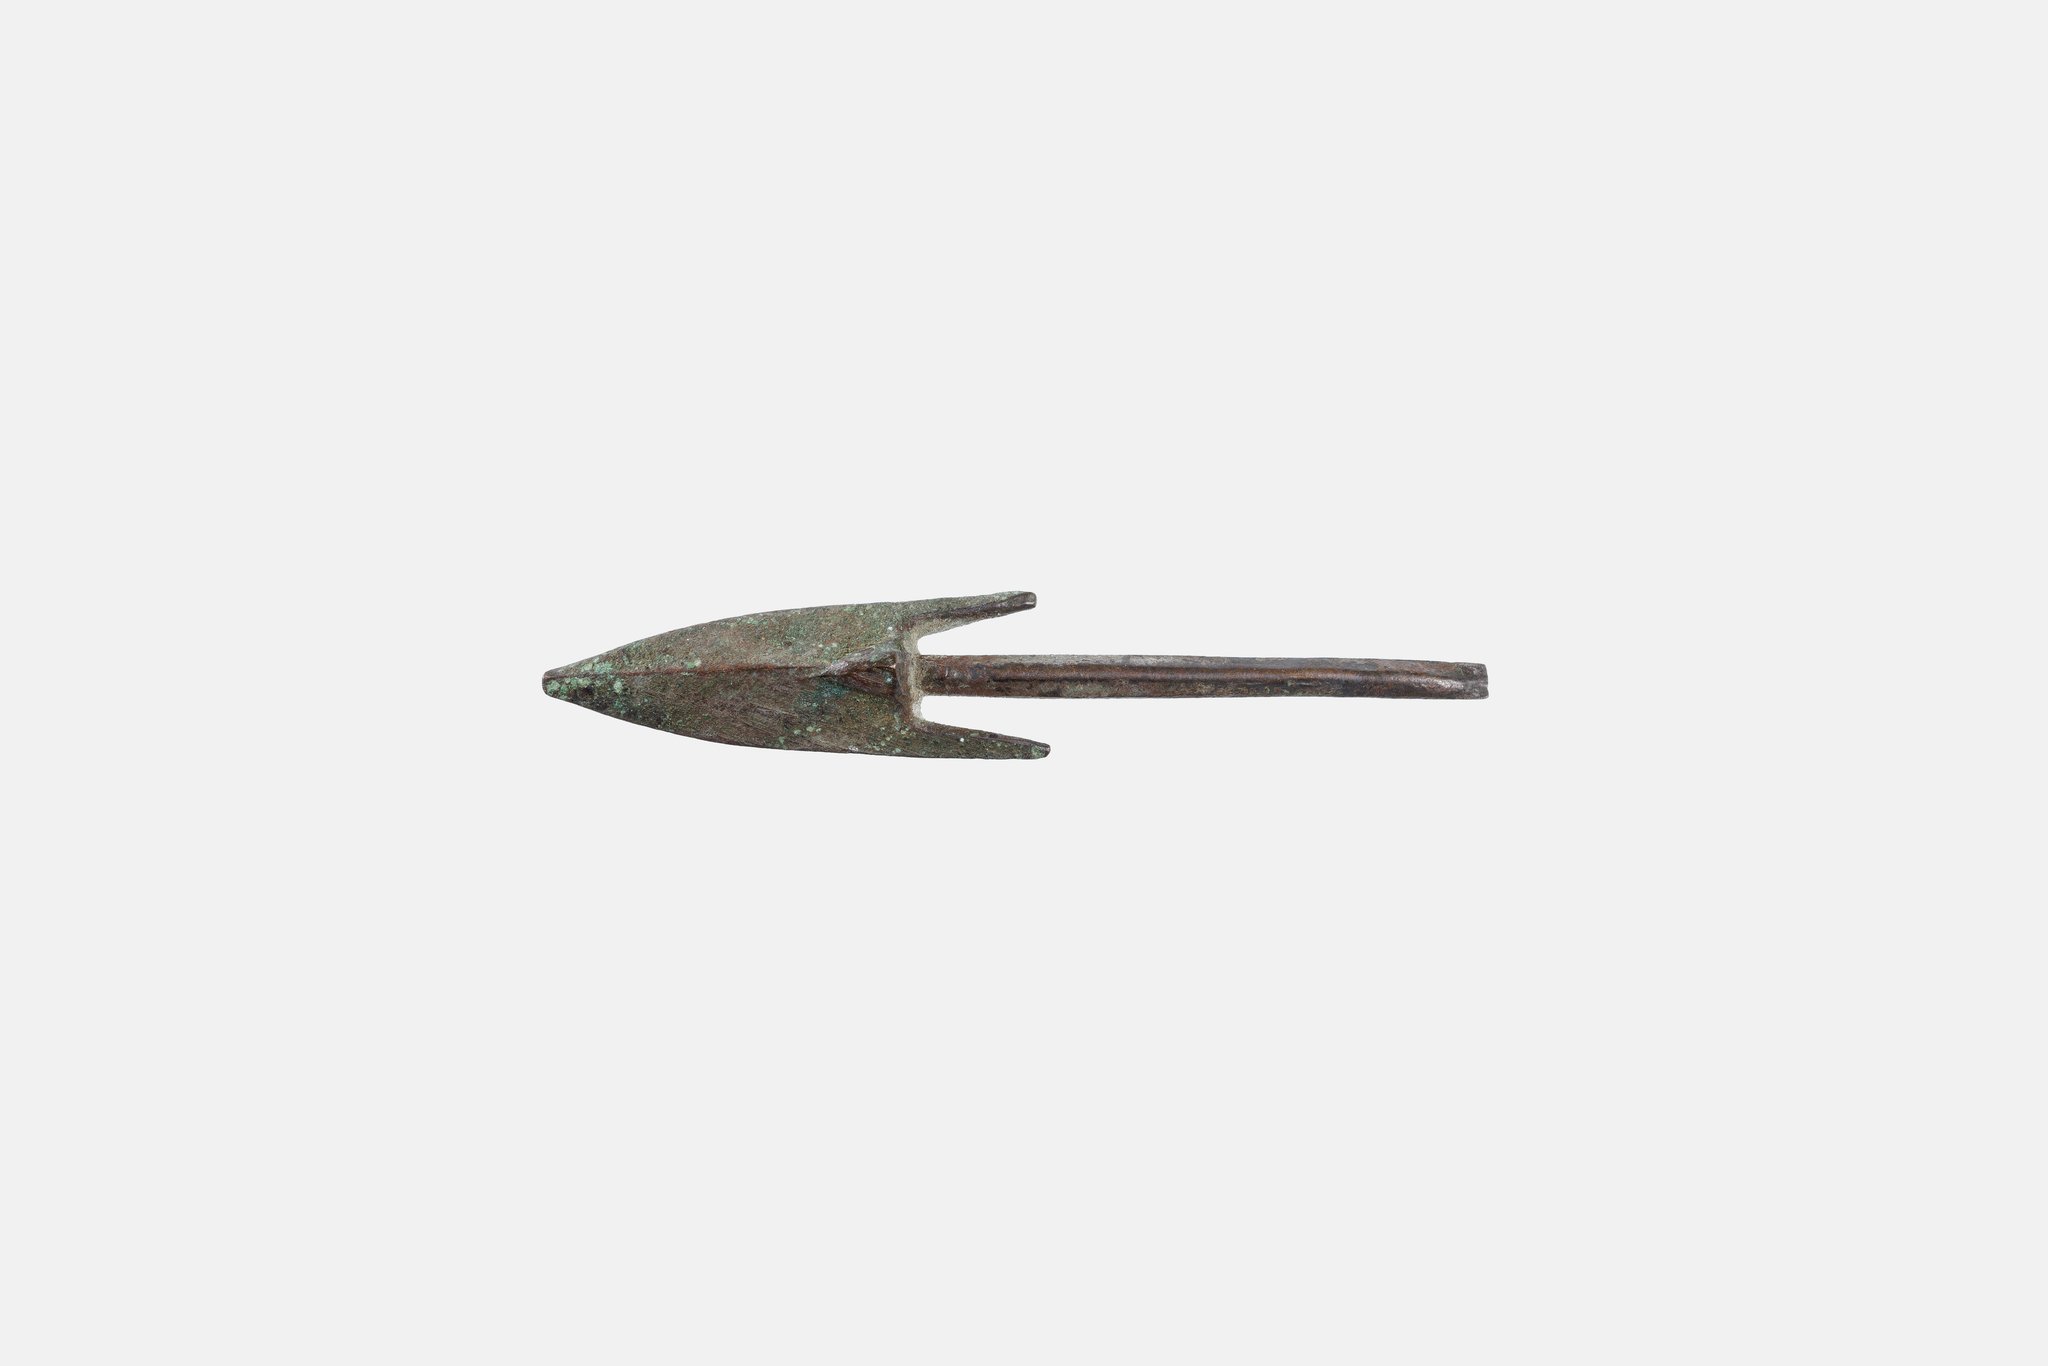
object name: arrowhead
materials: iron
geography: egypt